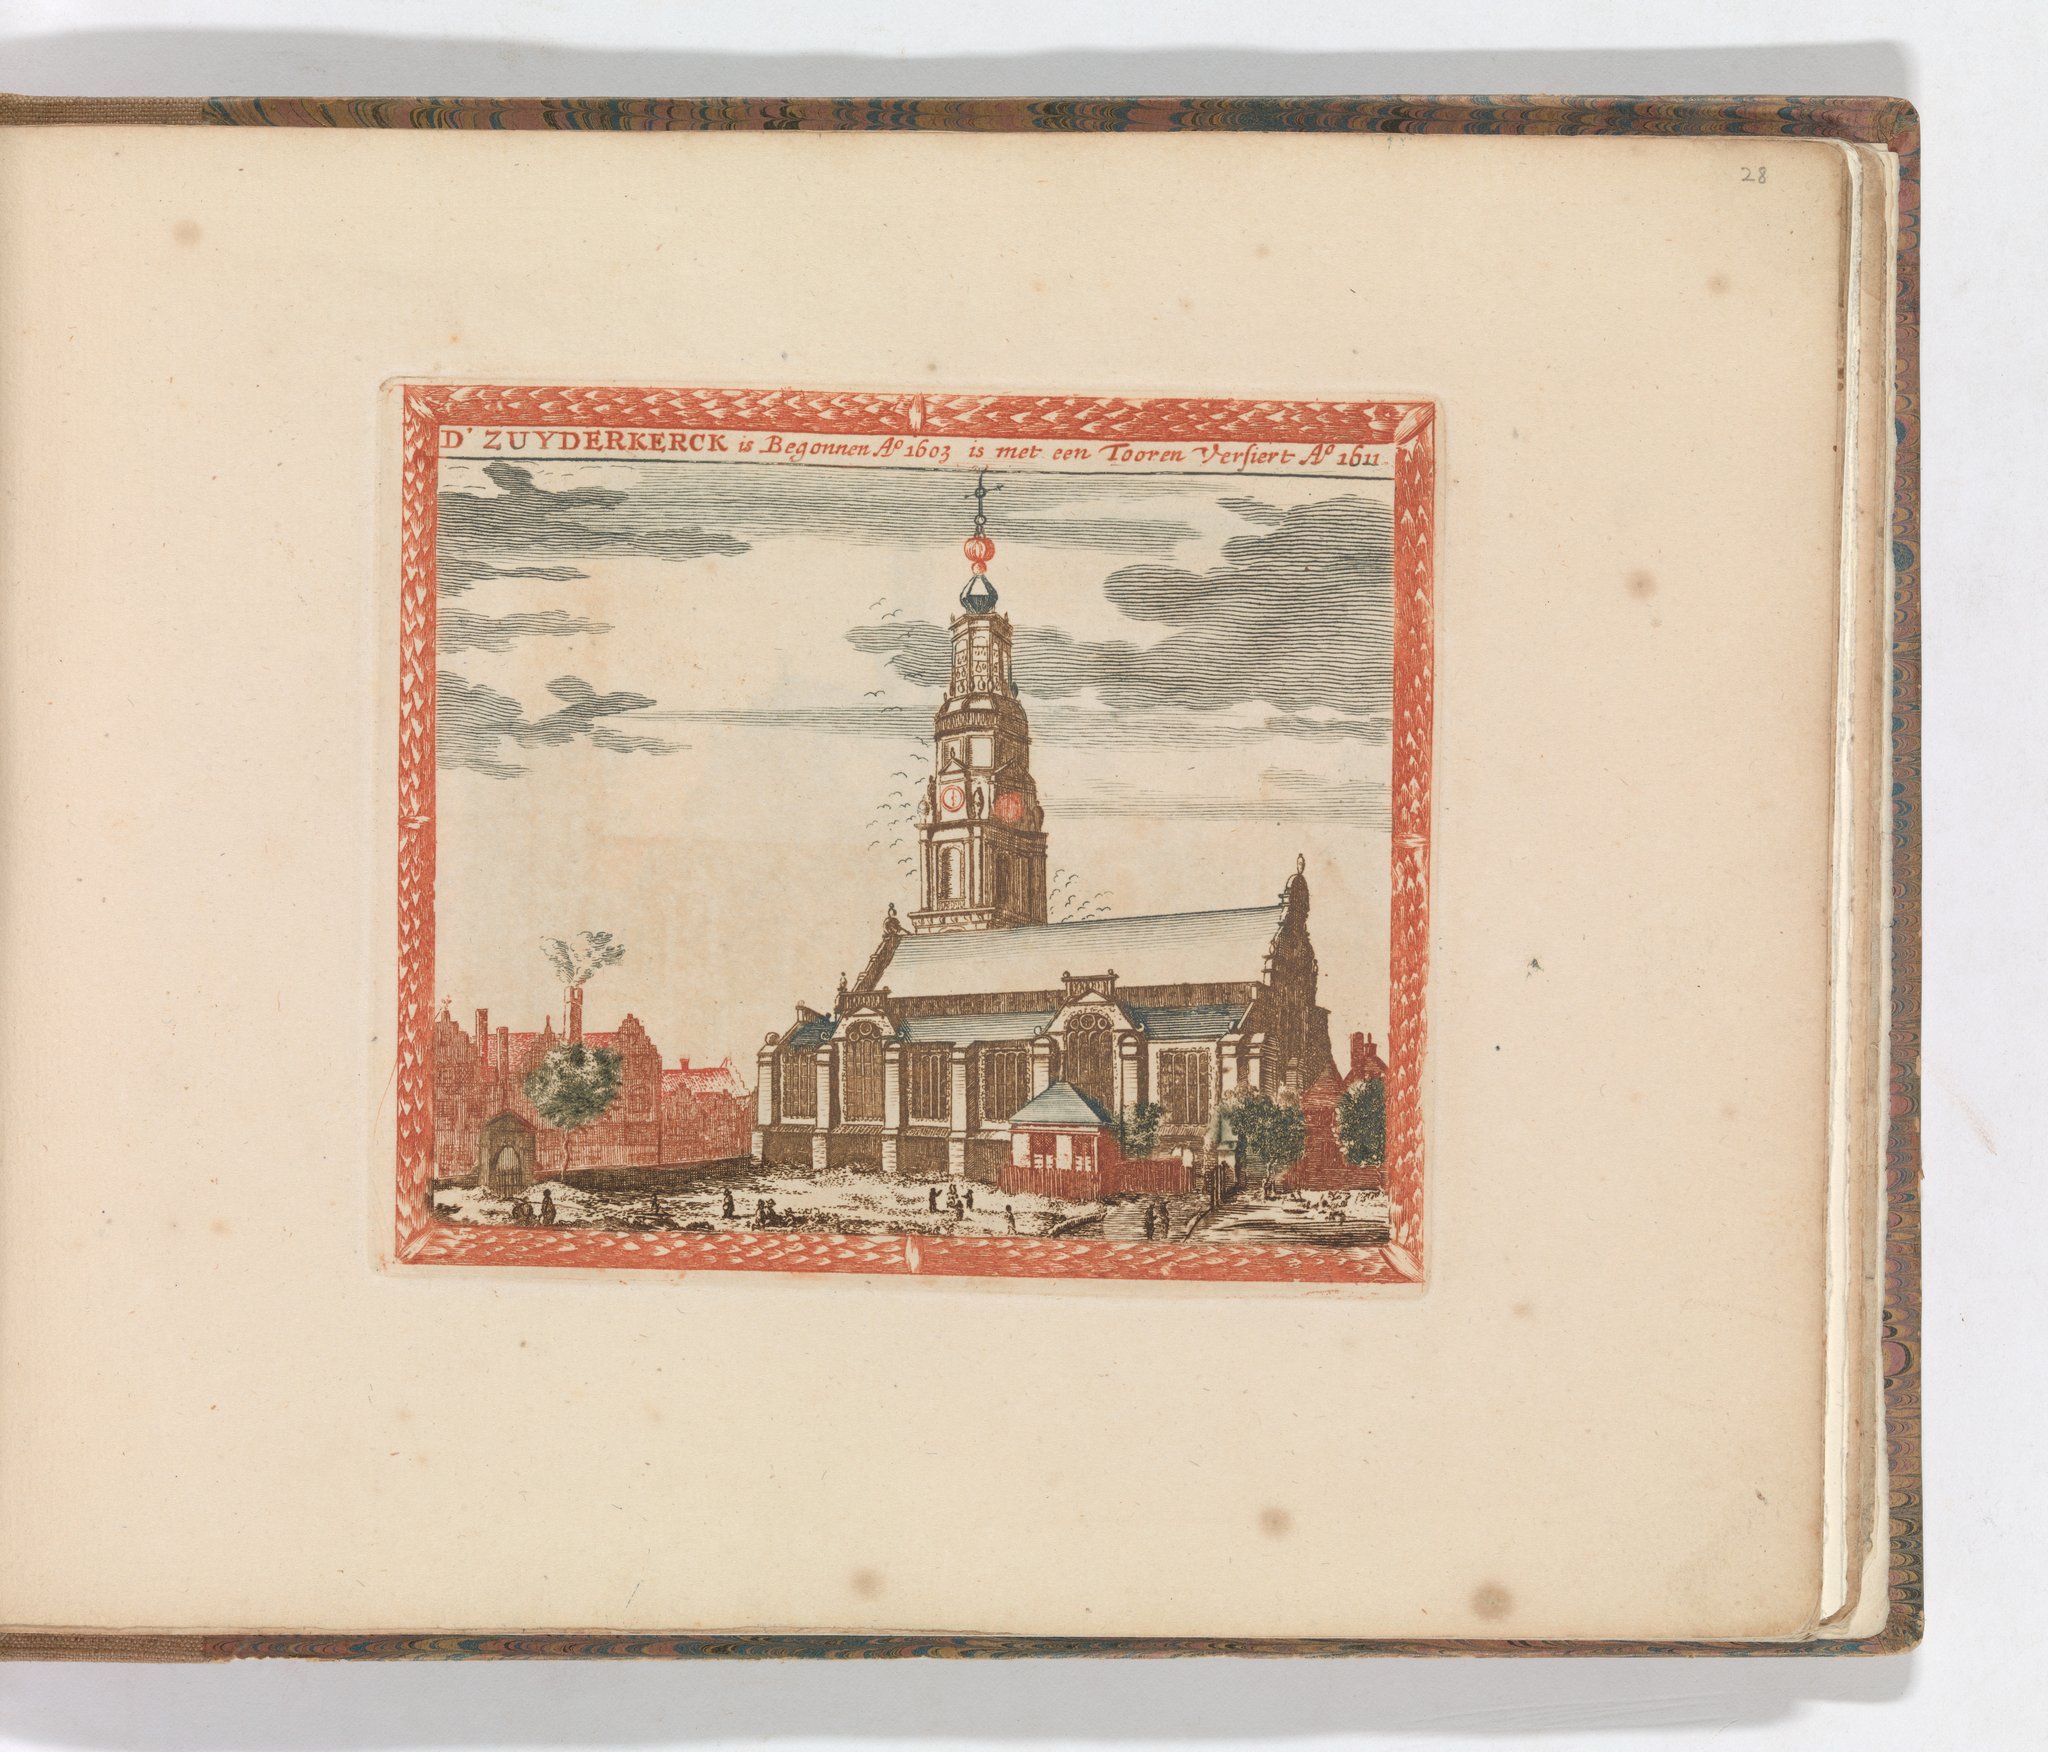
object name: book print ornament architecture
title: 'D' Zuyderkerck', in: Tooneel Der Voornaamste Nederlands Huizen, En Lust Hoven, Naar T Leven Afgebeeld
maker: carel allard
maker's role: publisher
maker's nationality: dutch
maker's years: 1648-1709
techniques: engraving, lithography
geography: amsterdam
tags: cities,churches